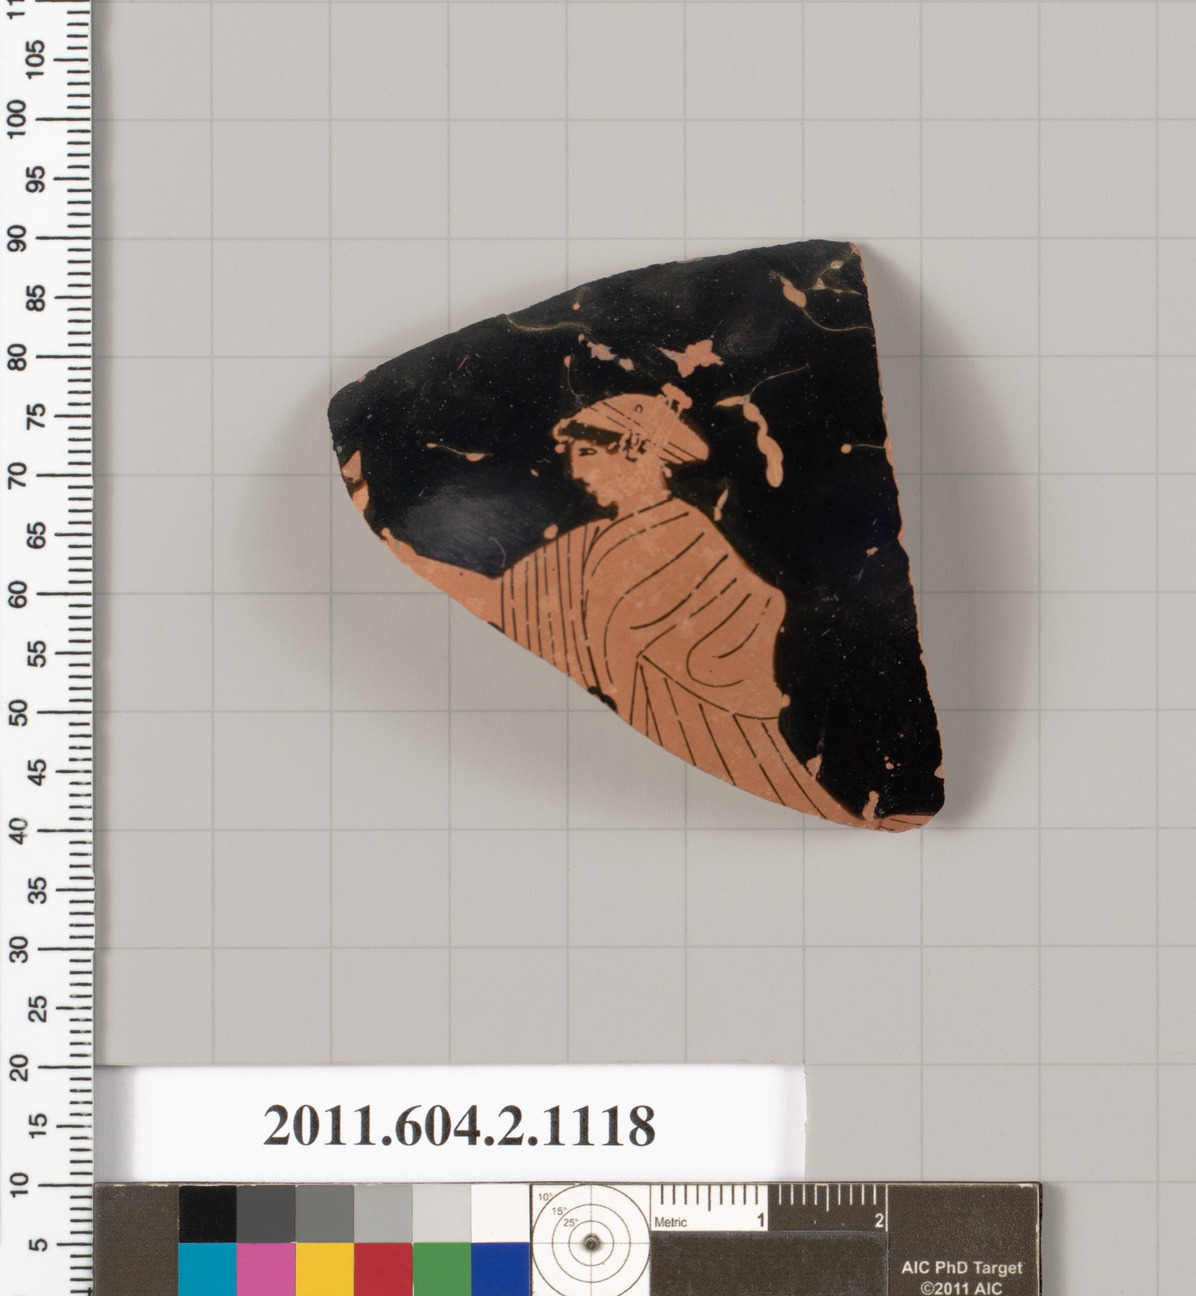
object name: lekythos fragment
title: Terracotta fragment of a squat lekythos (oil flask)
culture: greek, attic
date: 470-450 BCE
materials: terracotta